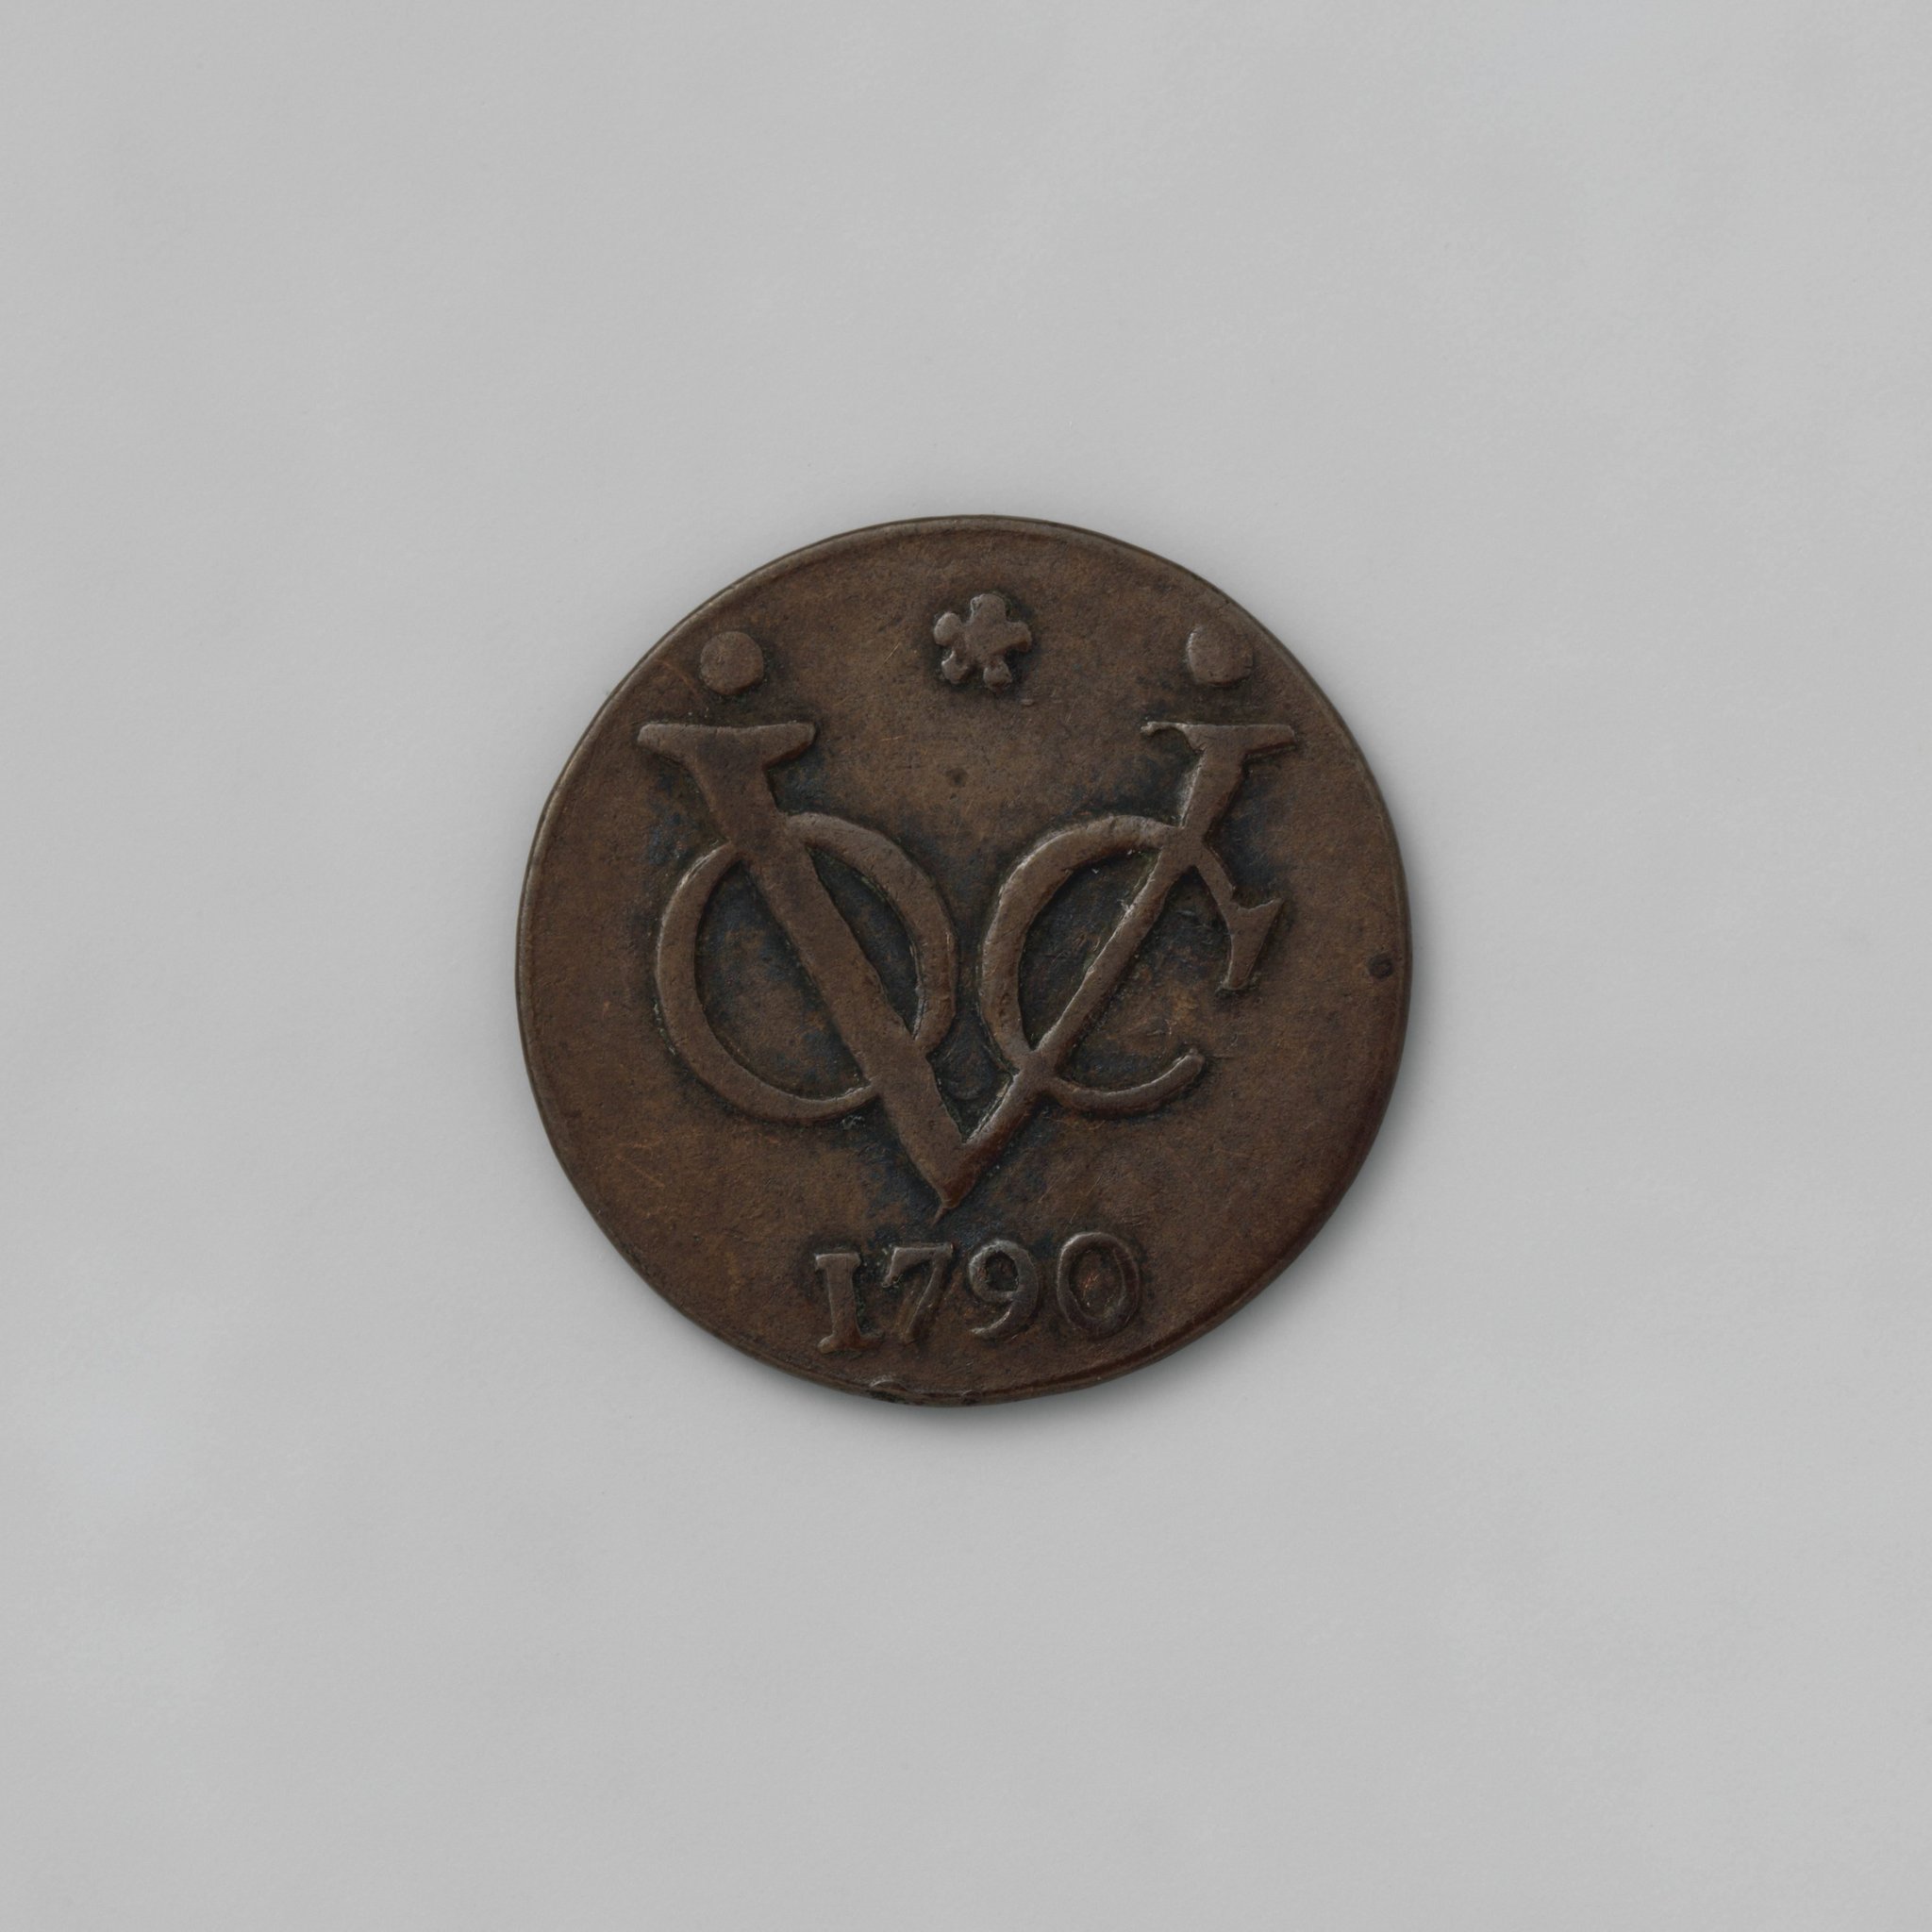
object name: coin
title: Duit van de VOC uit Westfriesland, 1790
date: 1790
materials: copper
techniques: striking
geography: hoorn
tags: verenigde oostindische compagnie, west-friesland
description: Koperen munt. Voorzijde: gekroond wapenschild van Westfriesland. Keerzijde: monogram van de VOC, waarboven muntteken en waaronder jaartal. Gladde rand.